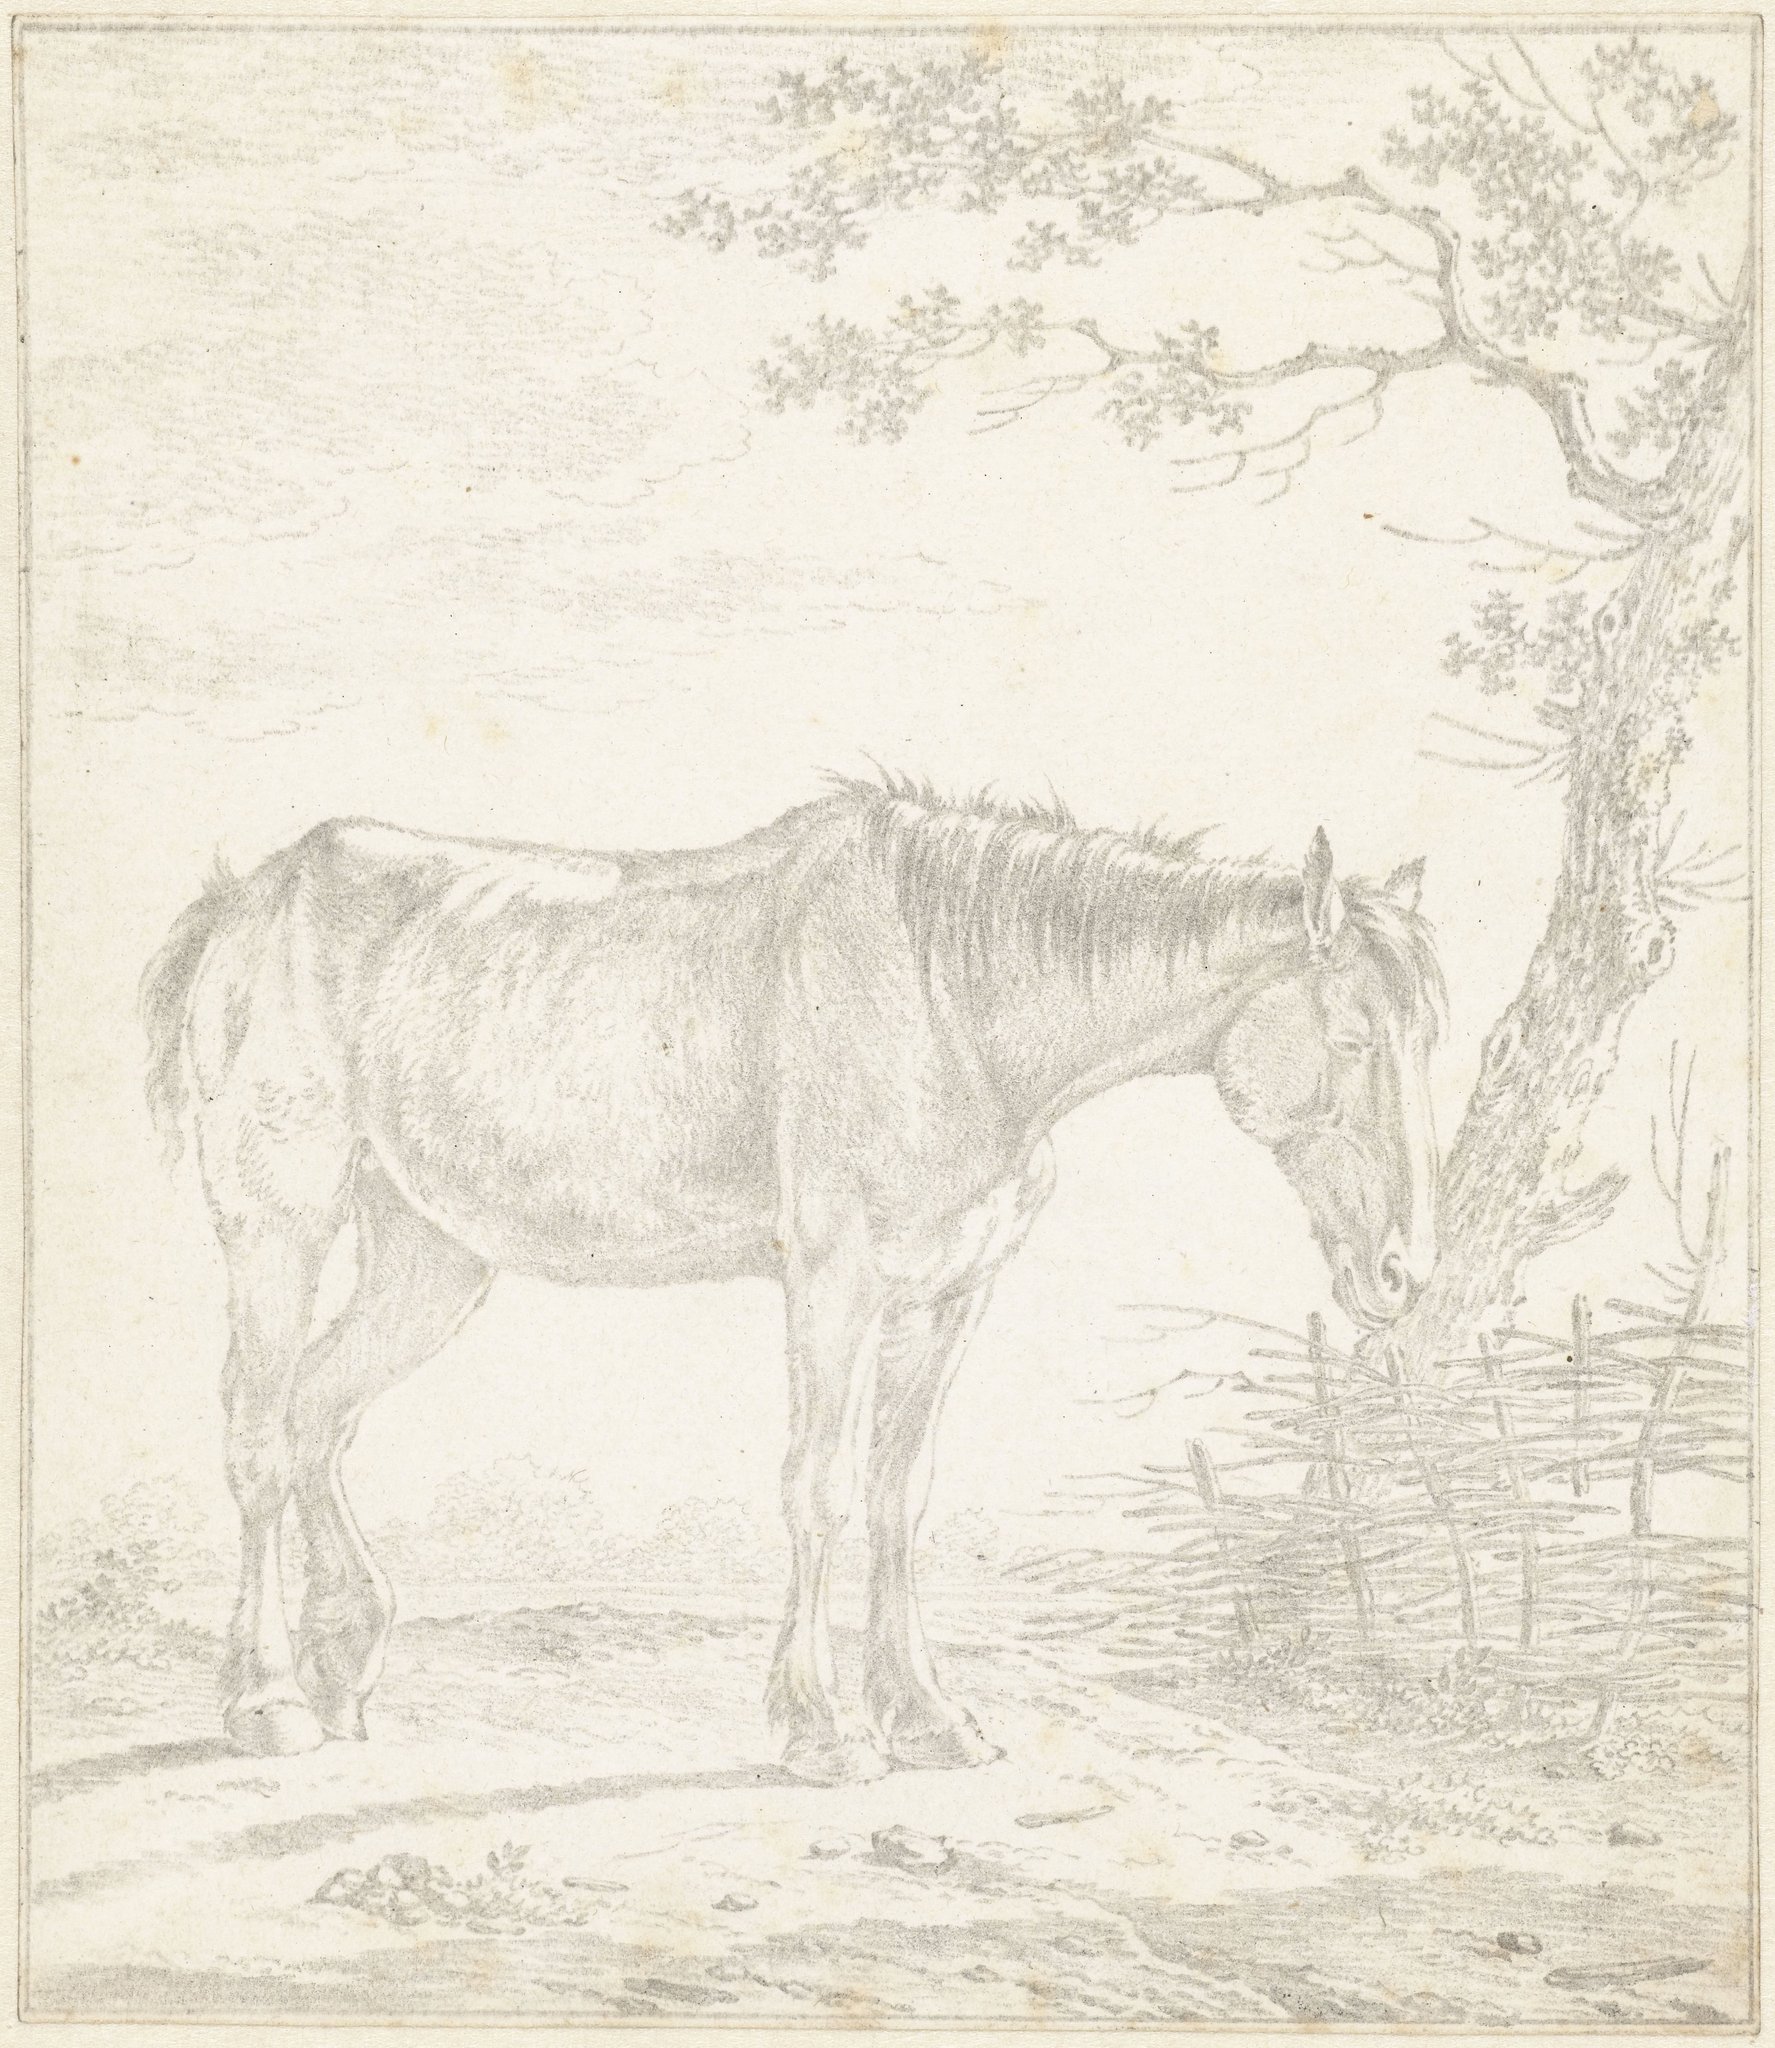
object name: drawing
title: Paard, staande bij een boom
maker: johannes christiaan janson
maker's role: draughtsman, painter, print maker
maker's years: 1763-1823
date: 1773-1823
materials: chalk, paper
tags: horse